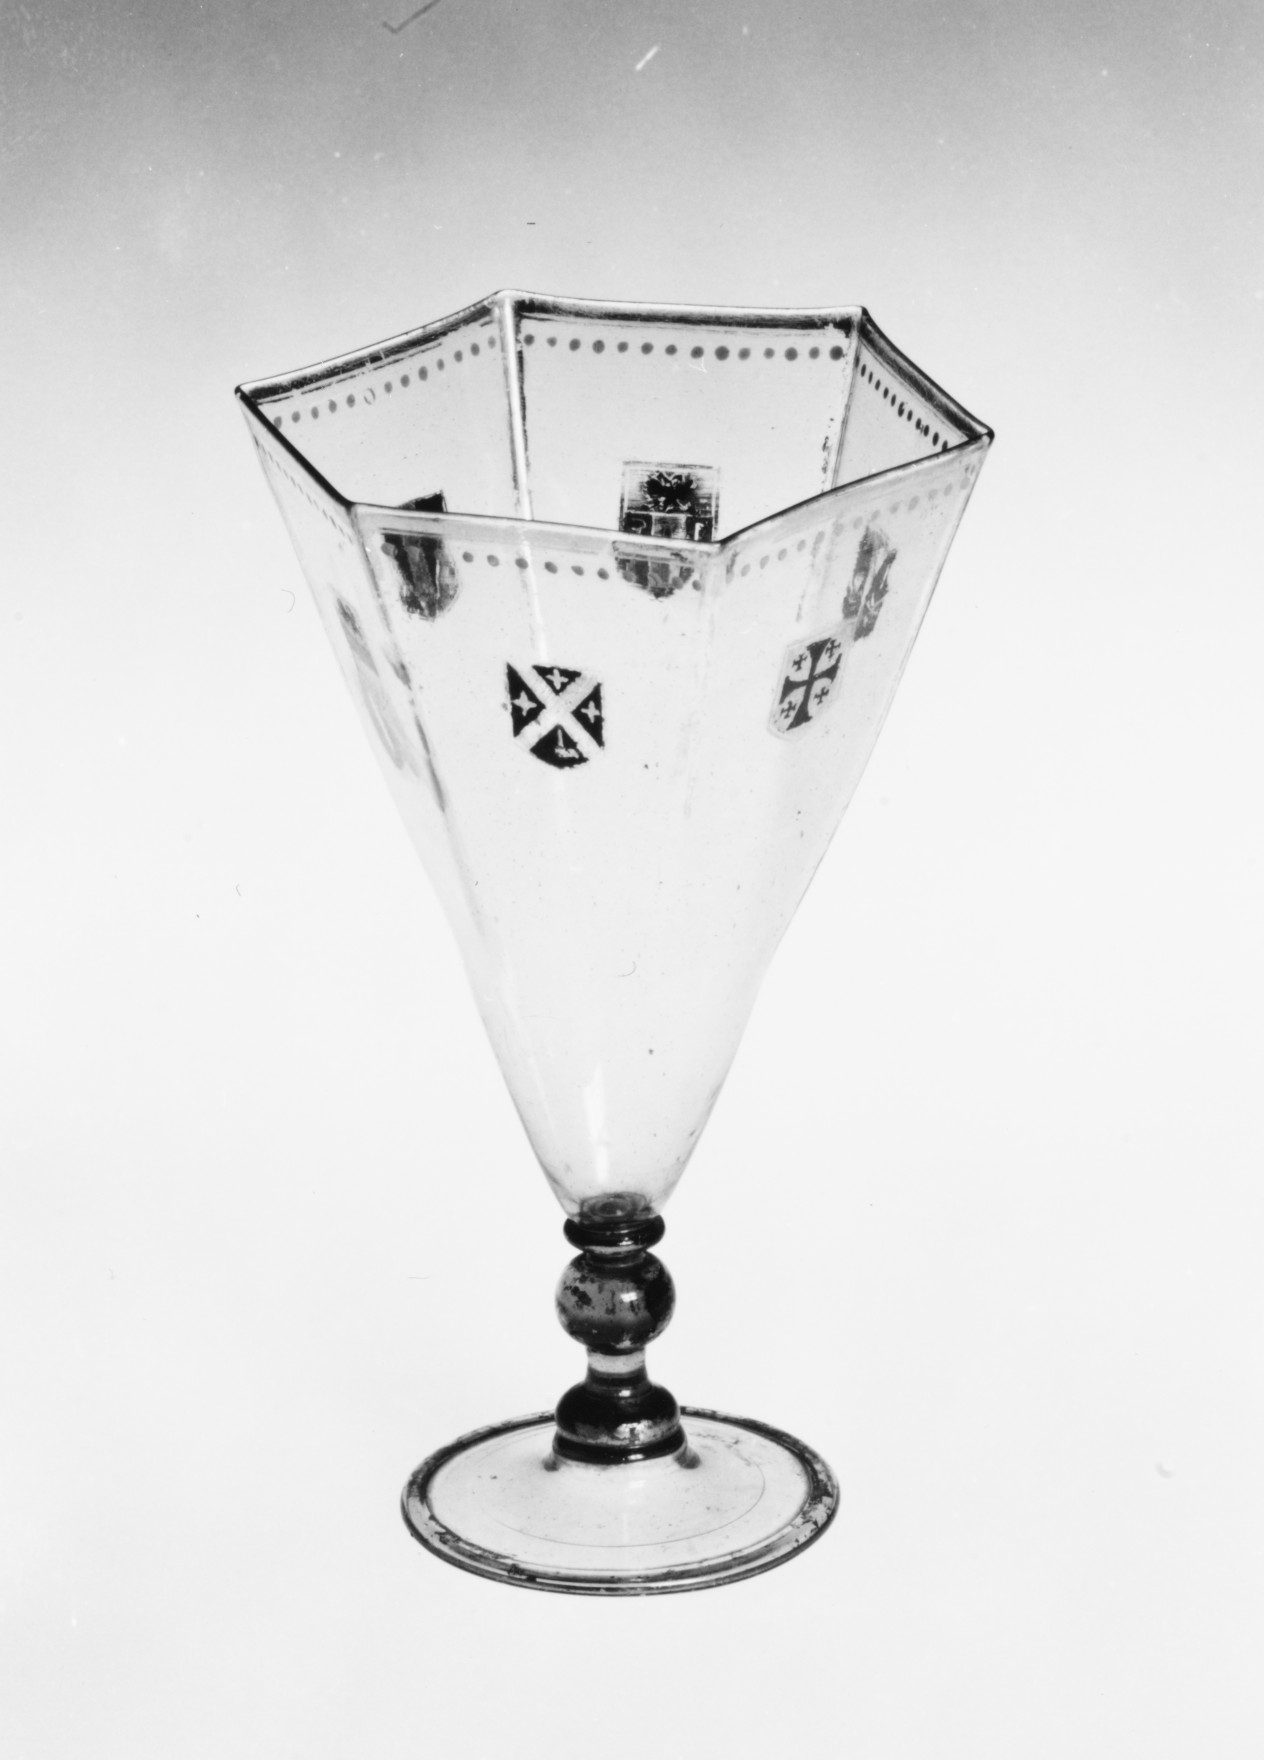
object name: goblet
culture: italian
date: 1867-1900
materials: gilt, glass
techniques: glassblowing, enamel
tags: coat of arms